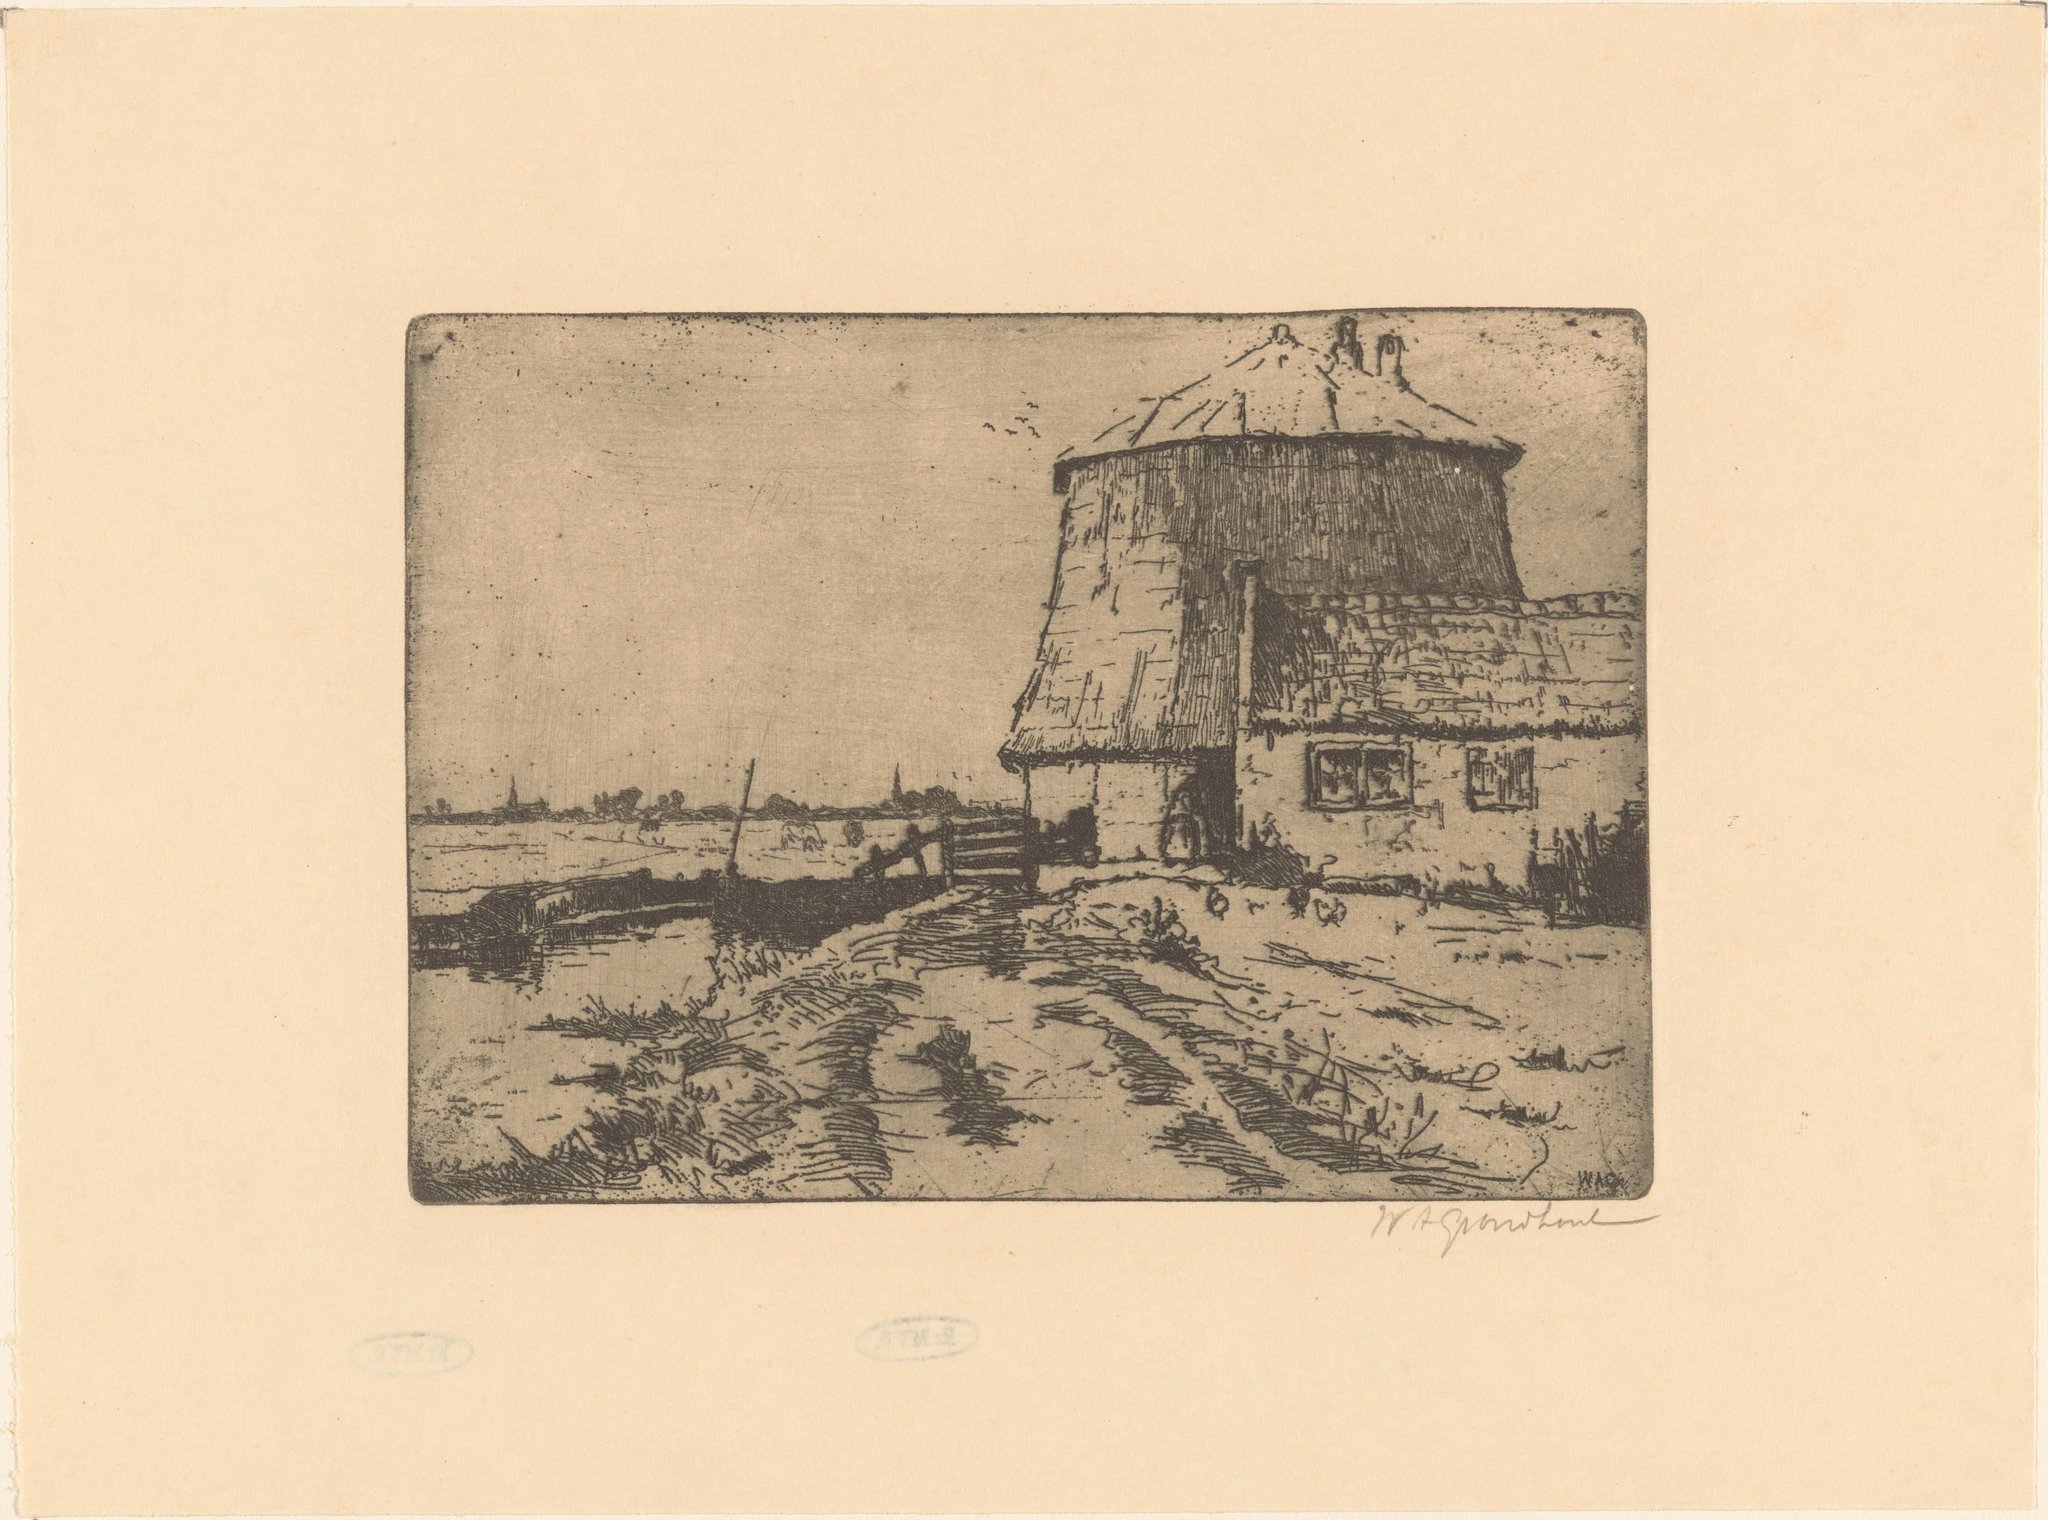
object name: print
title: Molen zonder wieken in Voorburg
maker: willem adrianus grondhout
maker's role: draughtsman, painter, print maker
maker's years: 1878-1934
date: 1888-1934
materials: paper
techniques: etching, intaglio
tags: windmill in landscape, voorburg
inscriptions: collector's mark: Lugt 2228